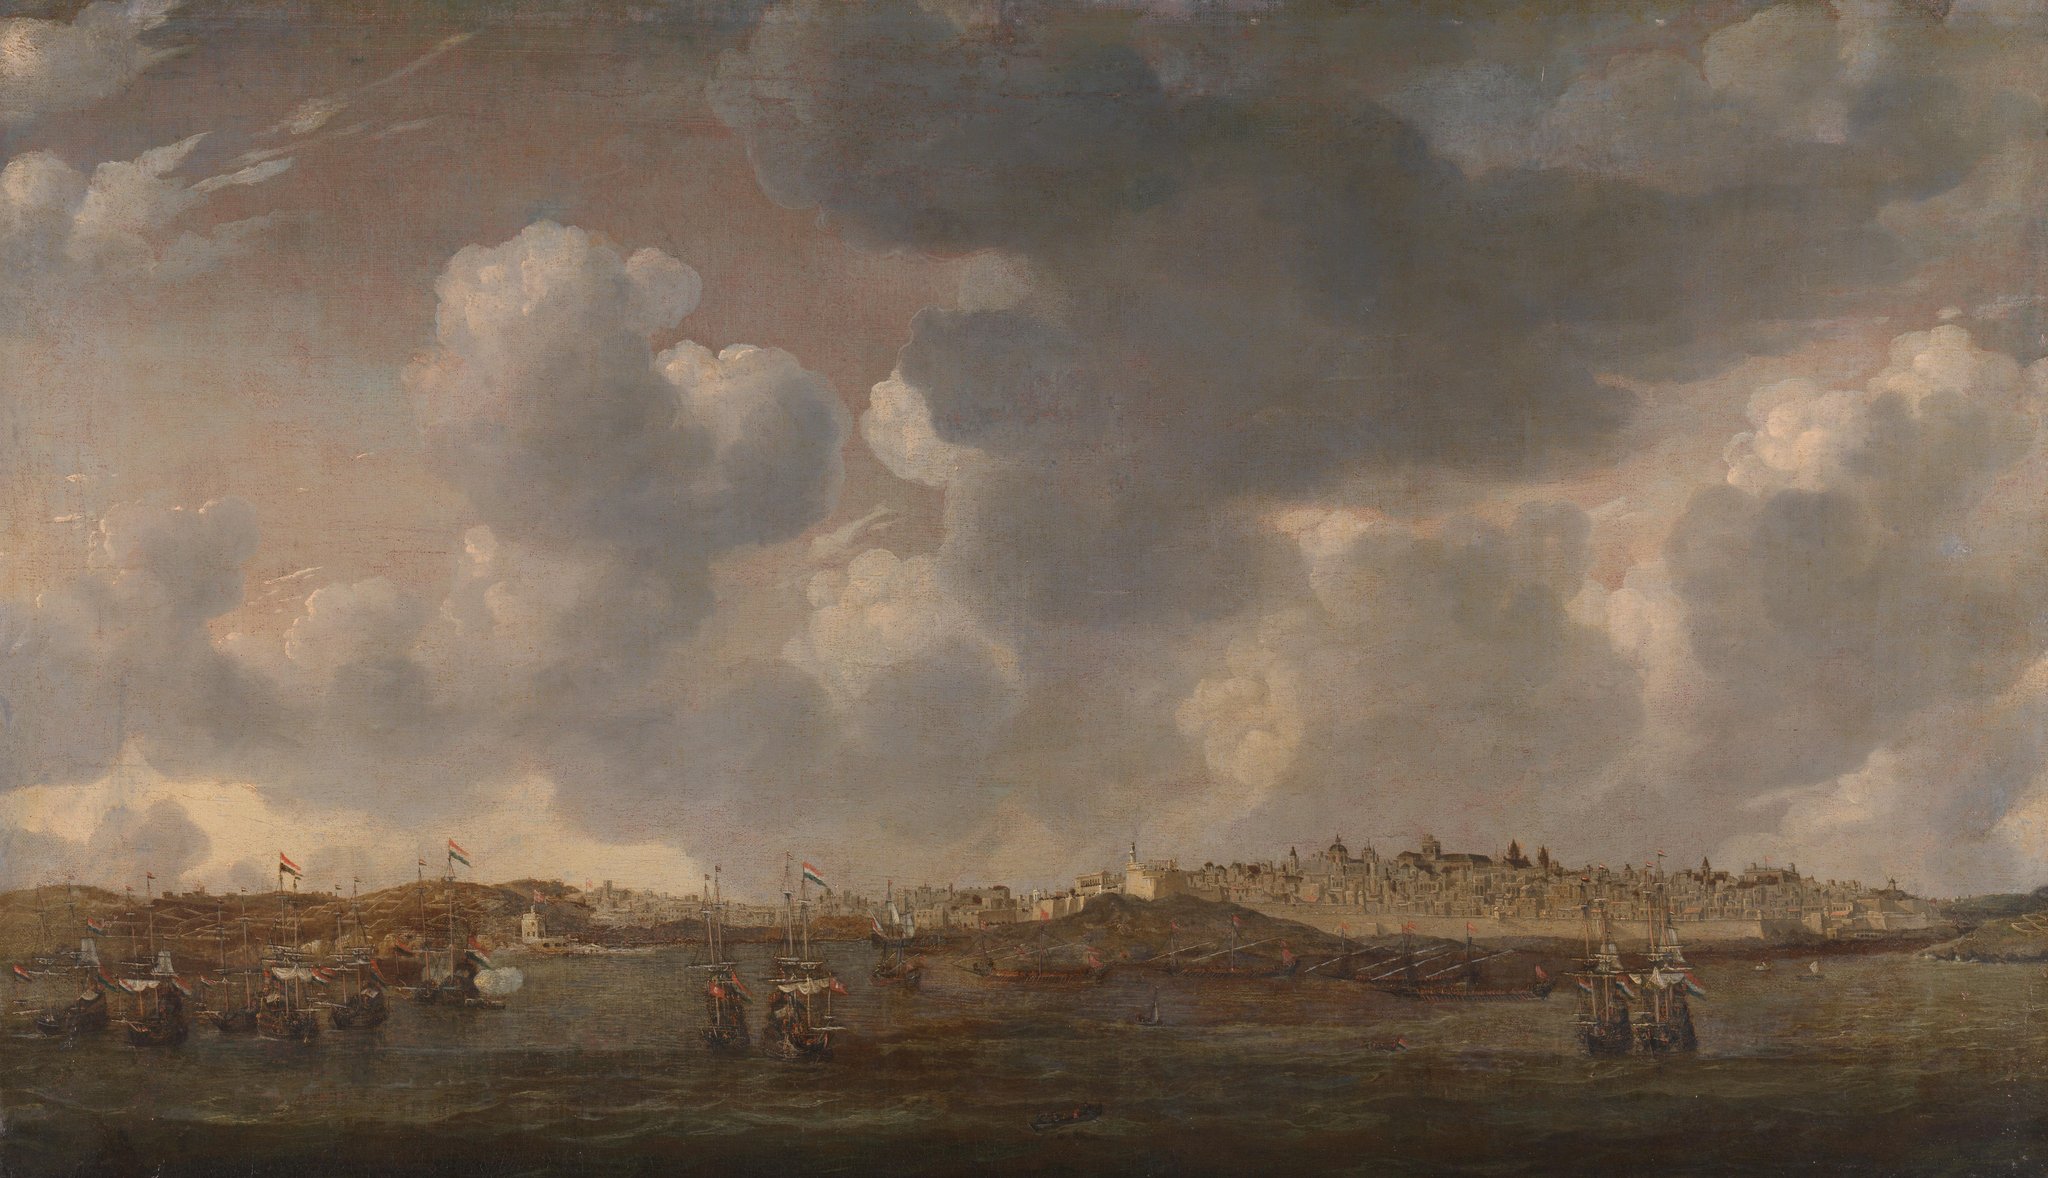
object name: painting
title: View of Salee, Morocco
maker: reinier nooms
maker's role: draughtsman, painter, print maker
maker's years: 1623-1664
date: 1662-1668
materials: canvas, oil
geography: amsterdam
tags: sailing-ship, sailing-boat, navy, coast, navy (+ sailing-ships)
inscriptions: signature, on a rock face: ‘R. Zeeman’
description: Four views of North-African cities. Reinier Nooms, c. 1665. To protect the Dutch merchant fleet, the navy took the fight the enemy, far beyond the country's coastal waters. The Mediterranean harbours shown here - Algiers, Tunis, Tripoli and Salee - were bases from which privateers attacked Dutch merchant shipping. Attempts were made to impose treaties on these cities using the threat of naval force. Between 1661 and 1663 Admiral Michiel de Ruyter cruised the Mediterranean Sea in an effort to stamp out piracy. De Ruyter's ship, de Liefde, is shown in the foreground of the view of Algiers. This series of paintings was displayed in one of the rooms of the Amsterdam Admiralty. The Republic's navy was divided into five regional admiralties, one of which was based in Amsterdam.